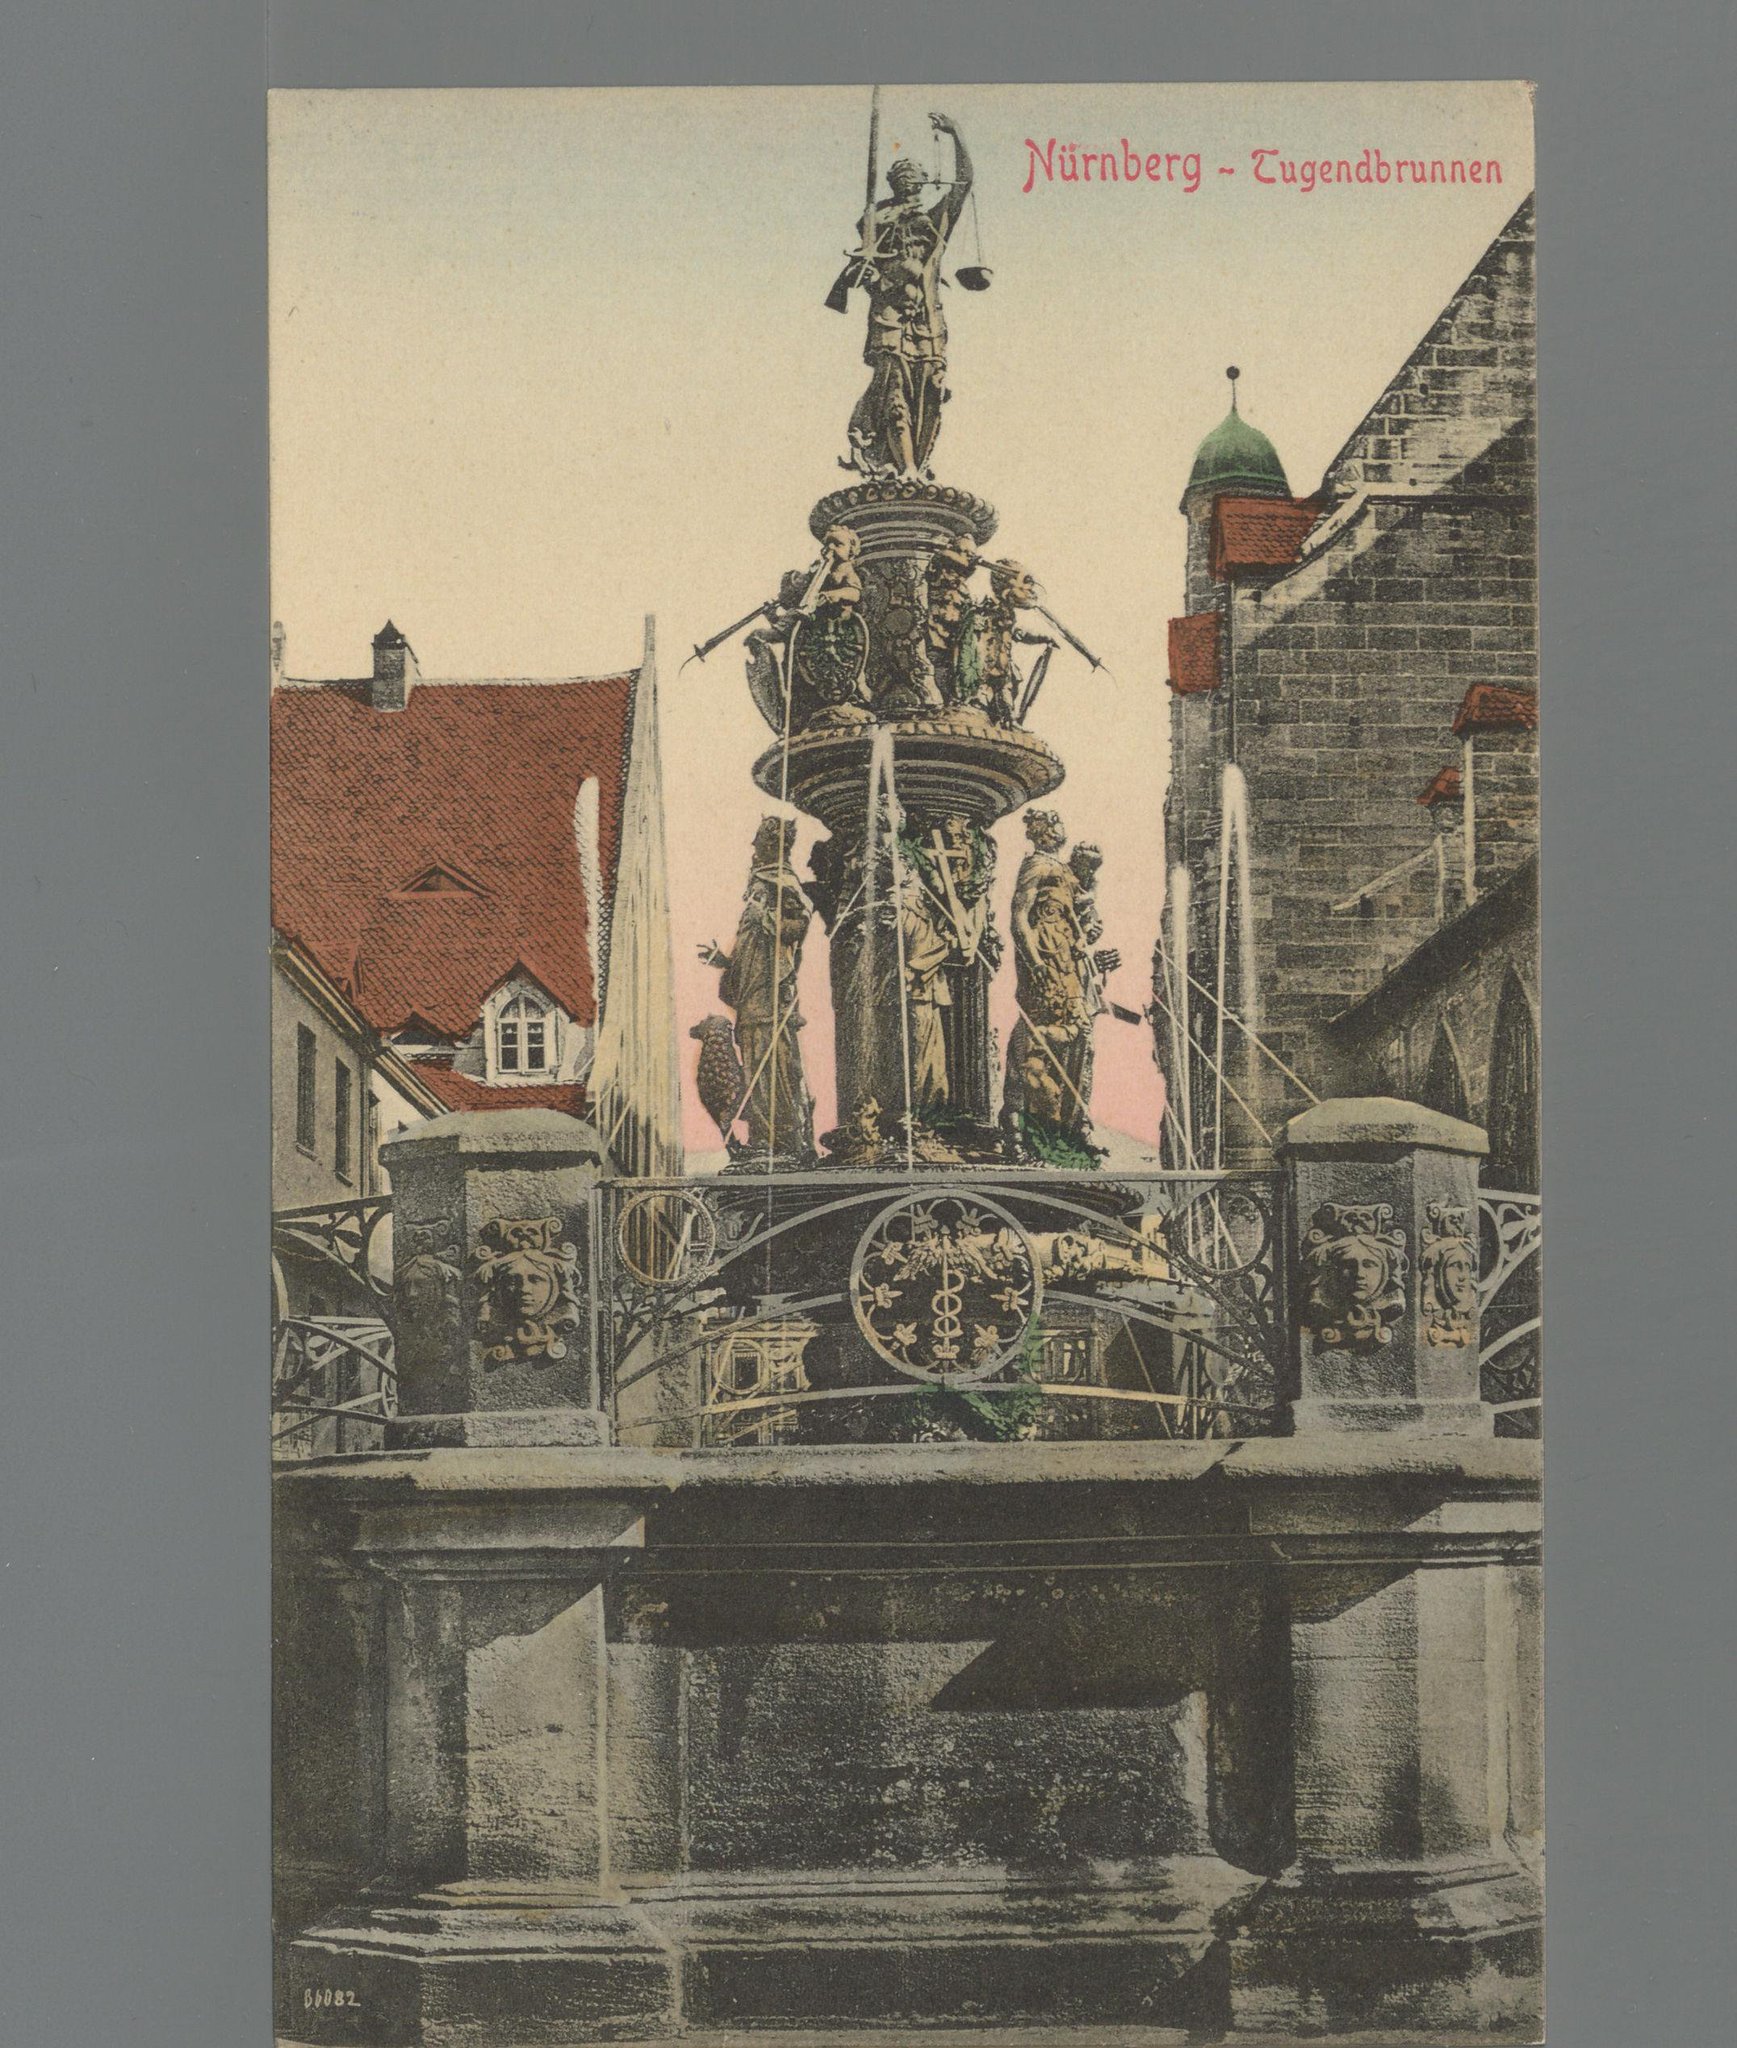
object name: photomechanical print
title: Nürnberg - Tugendbrunnen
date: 1905-1930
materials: cardboard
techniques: photograph, lithograph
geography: nuremberg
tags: ornamental fountain